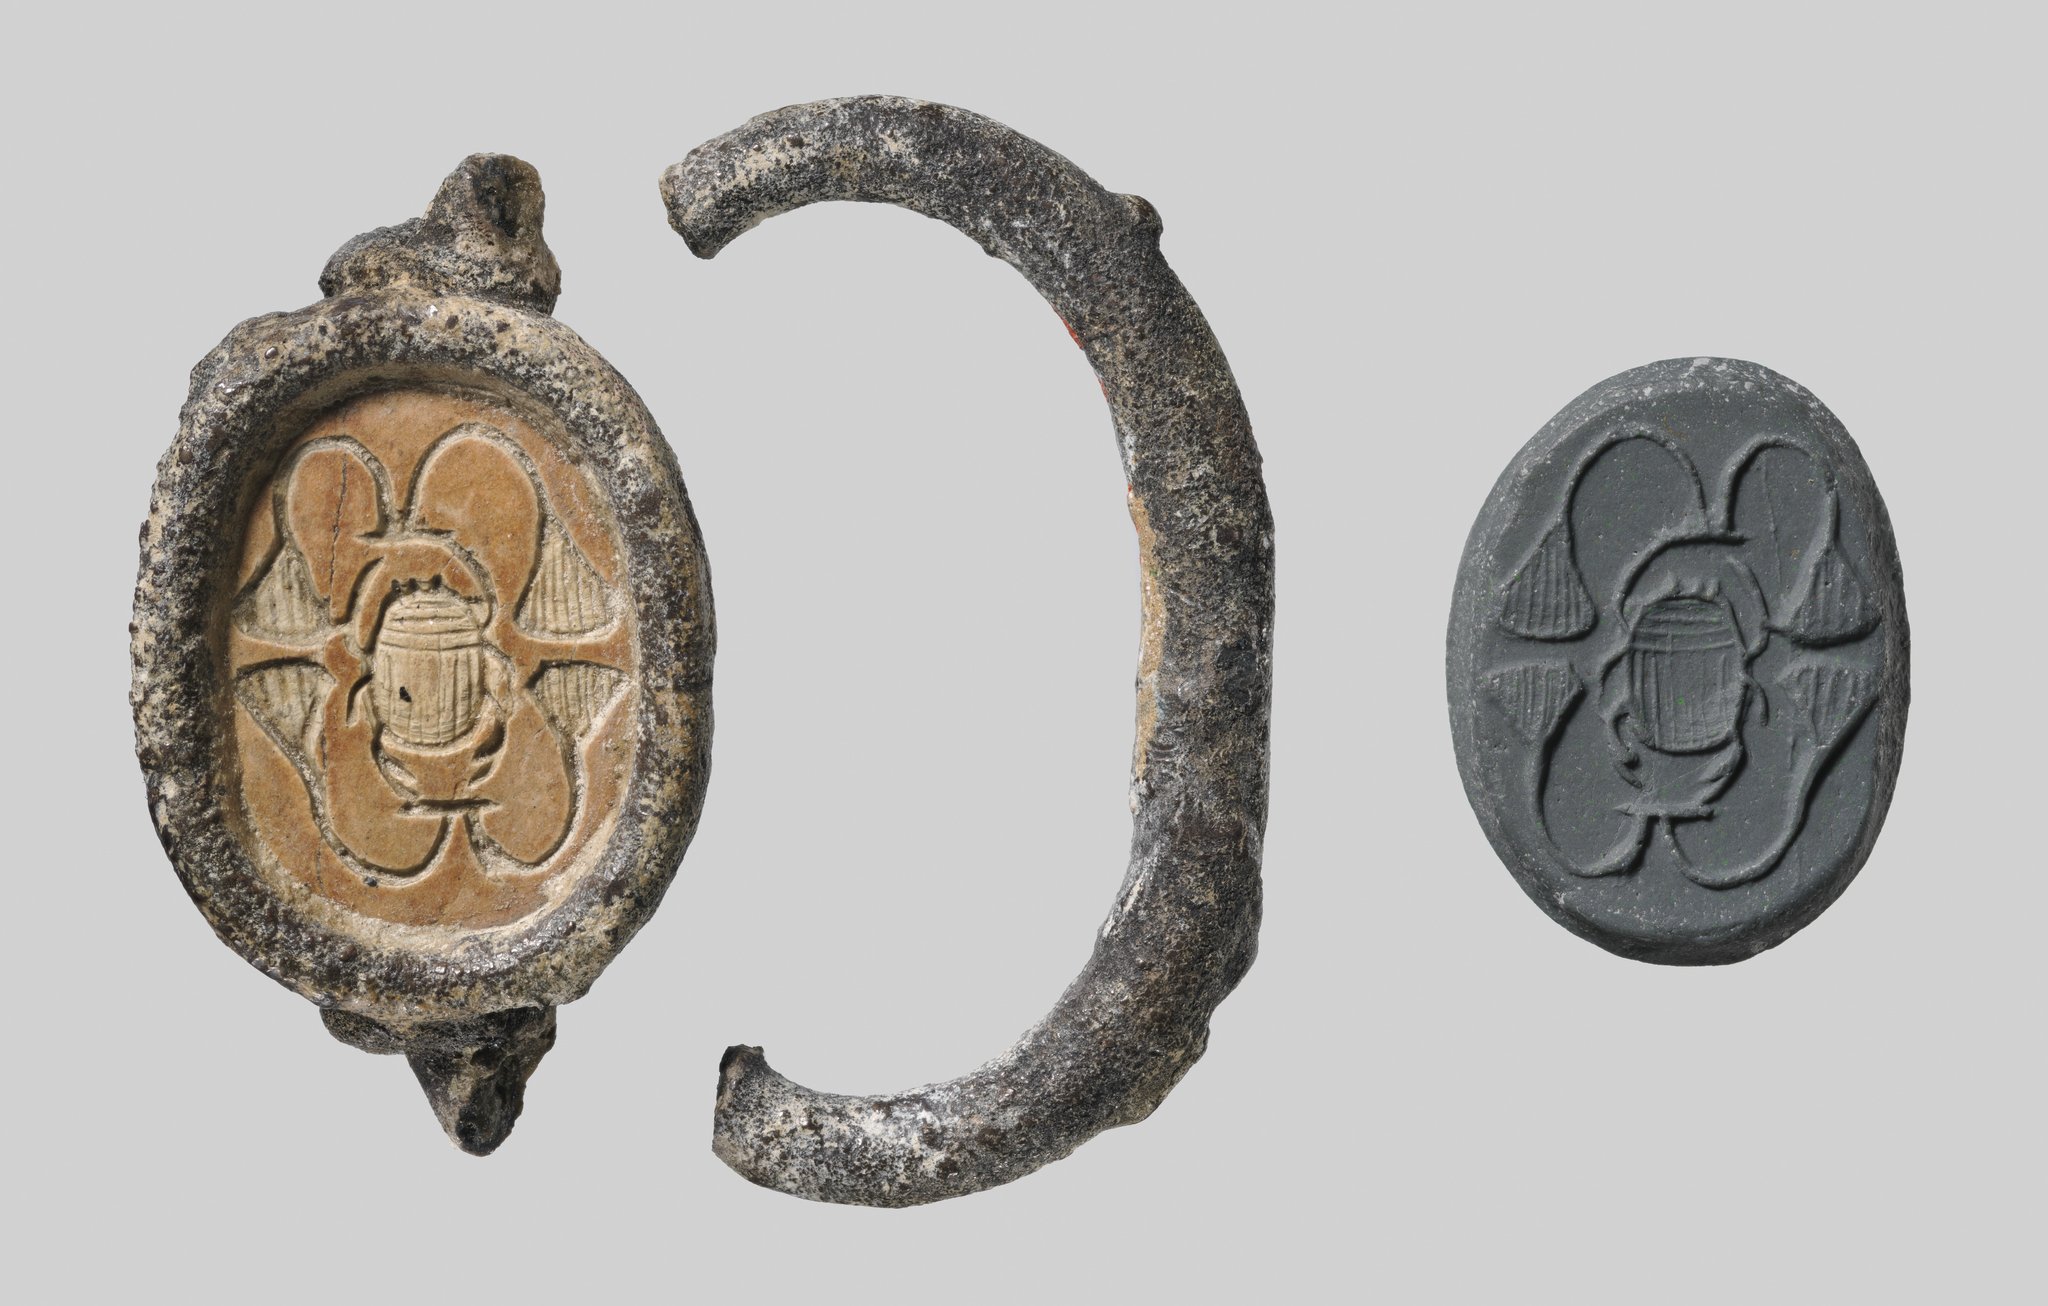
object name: ring, pendant, with scarab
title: Silver pendant ring with scarab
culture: phoenician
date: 900-701 BCE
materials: silver, stone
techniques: glazing